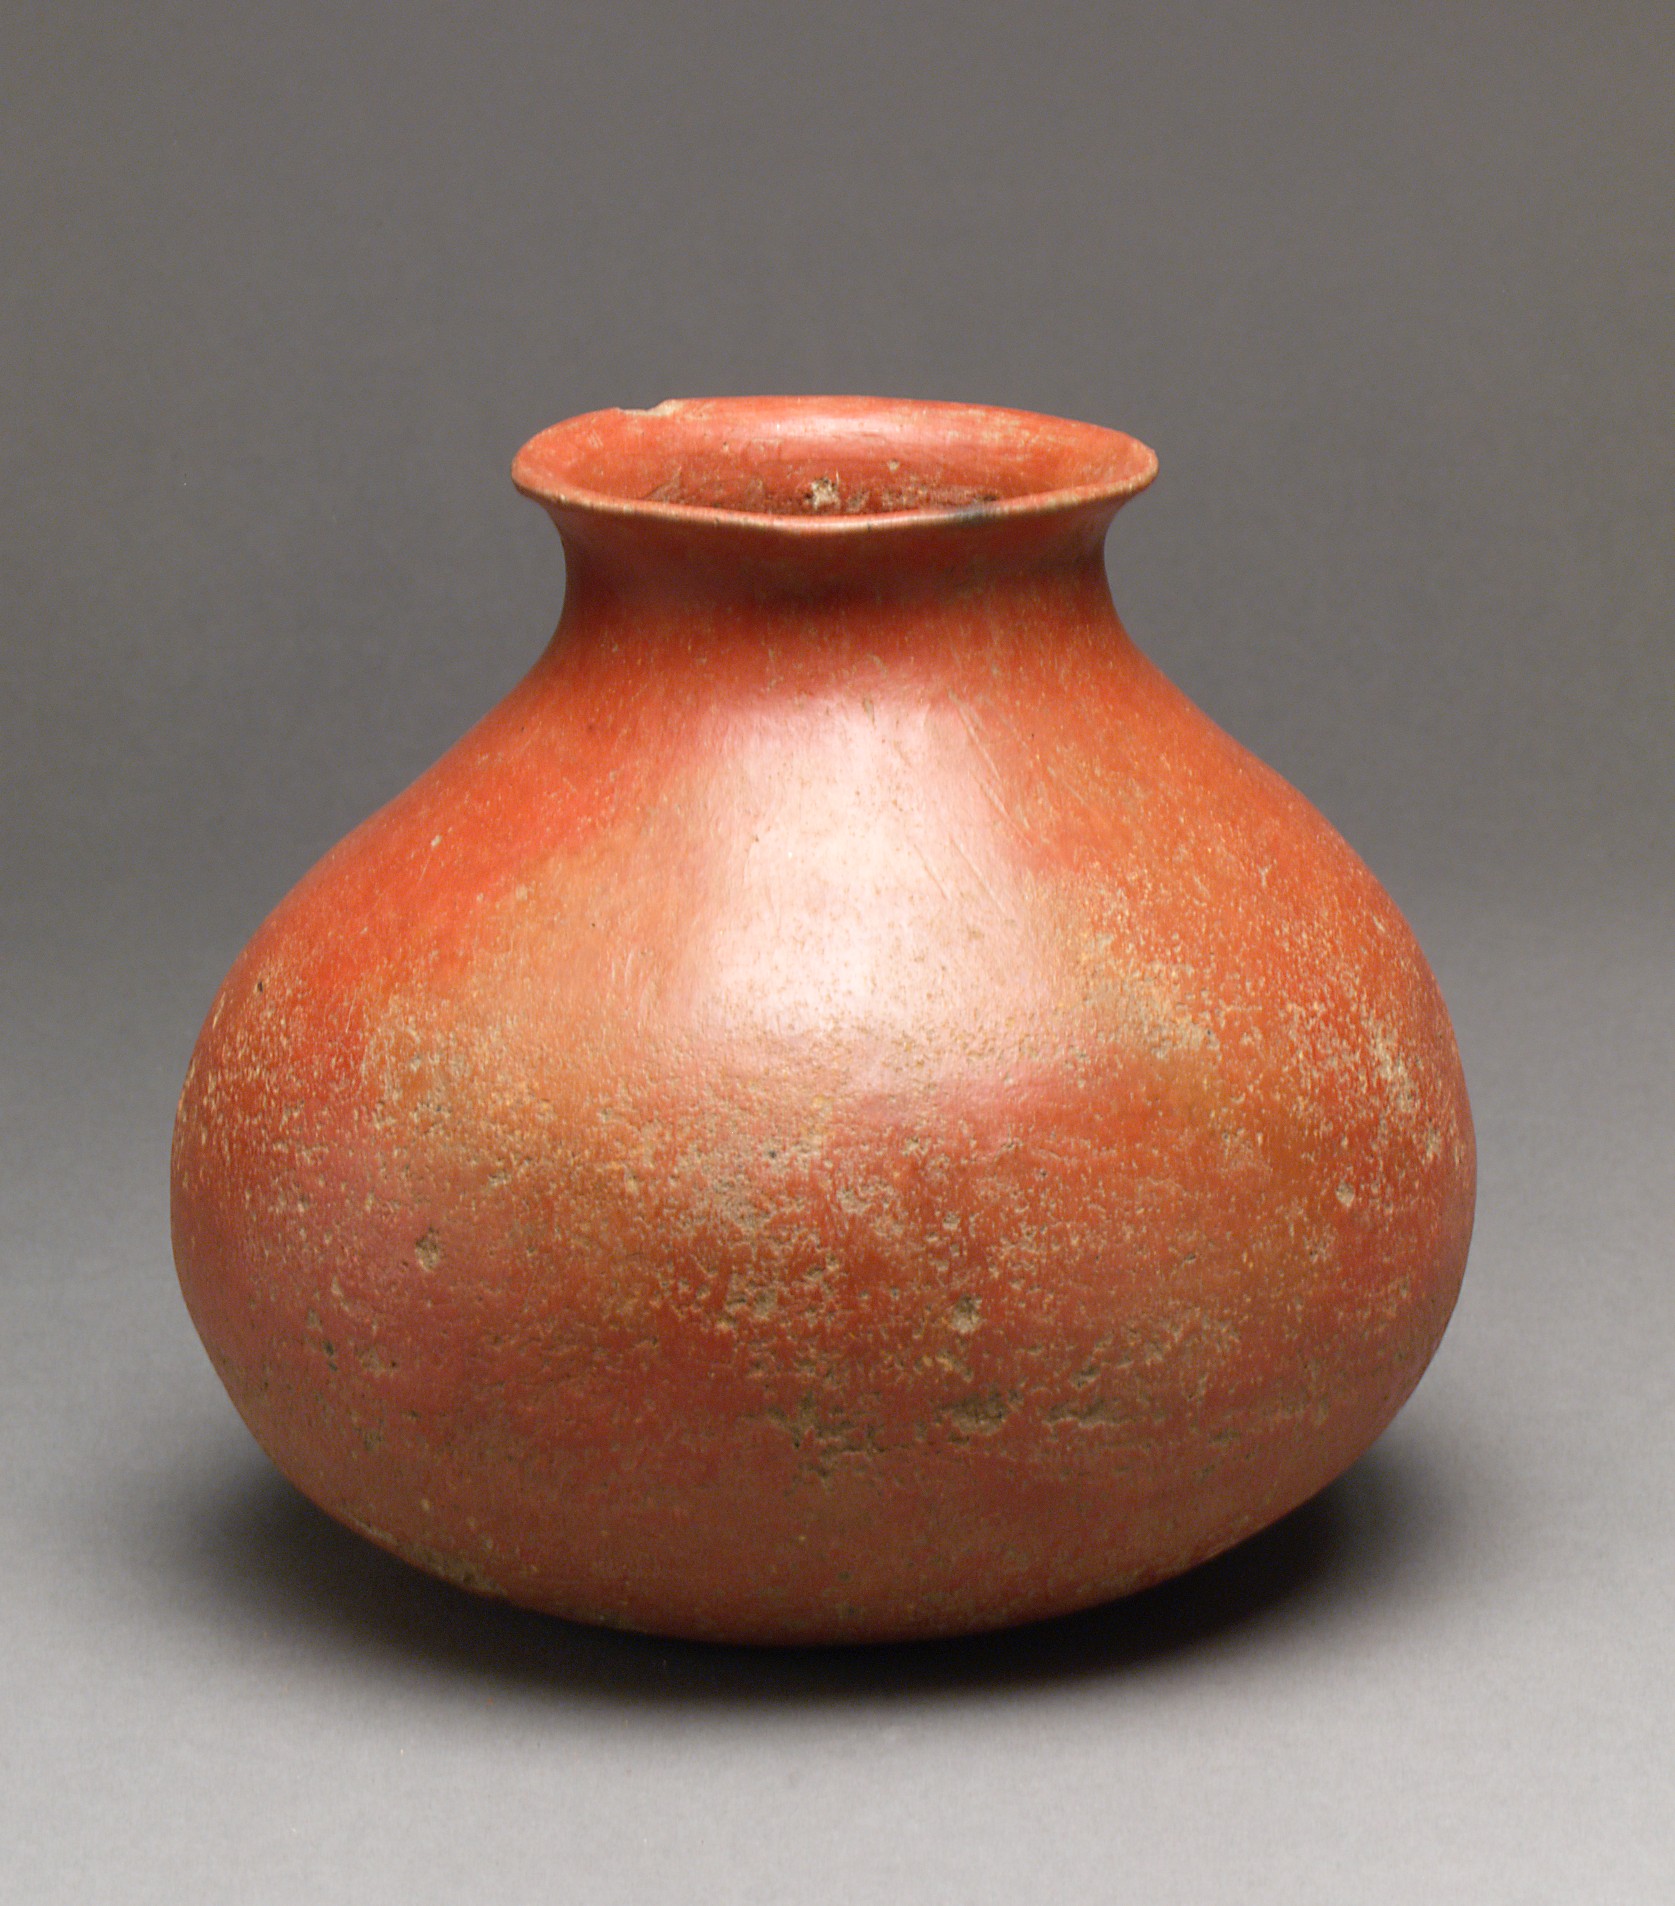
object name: jar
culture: korean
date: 400-301 BCE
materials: earthenware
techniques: burnishing